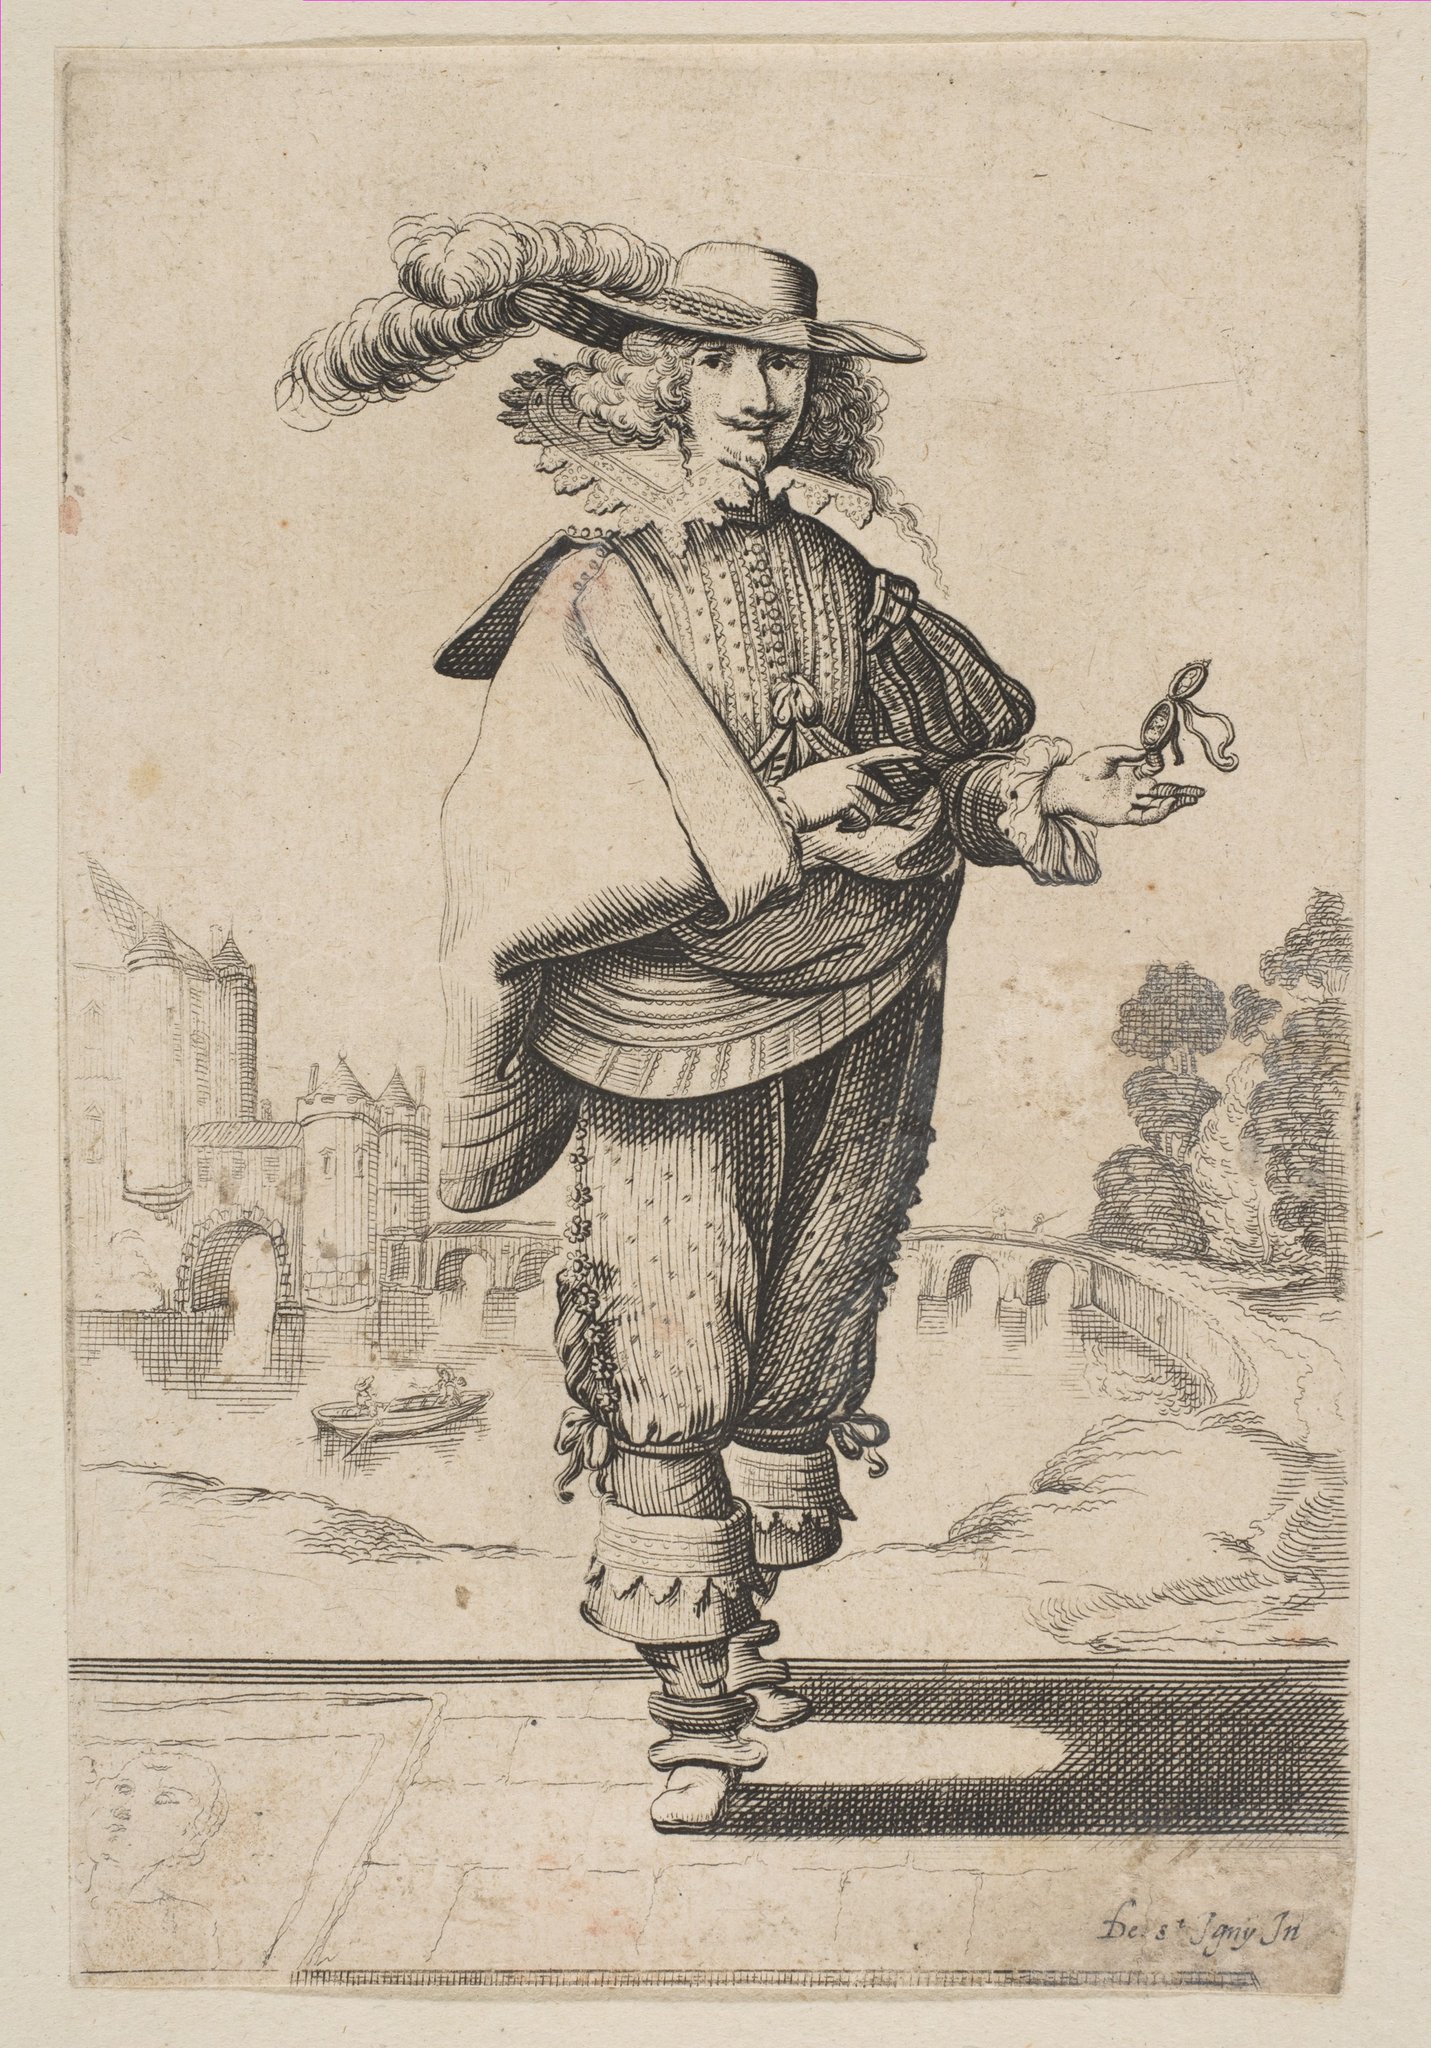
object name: print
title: The Amorous Widower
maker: anonymous, french, 17th century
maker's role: artist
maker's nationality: french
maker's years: 1600-1700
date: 1629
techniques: etching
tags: bridges,men,boats